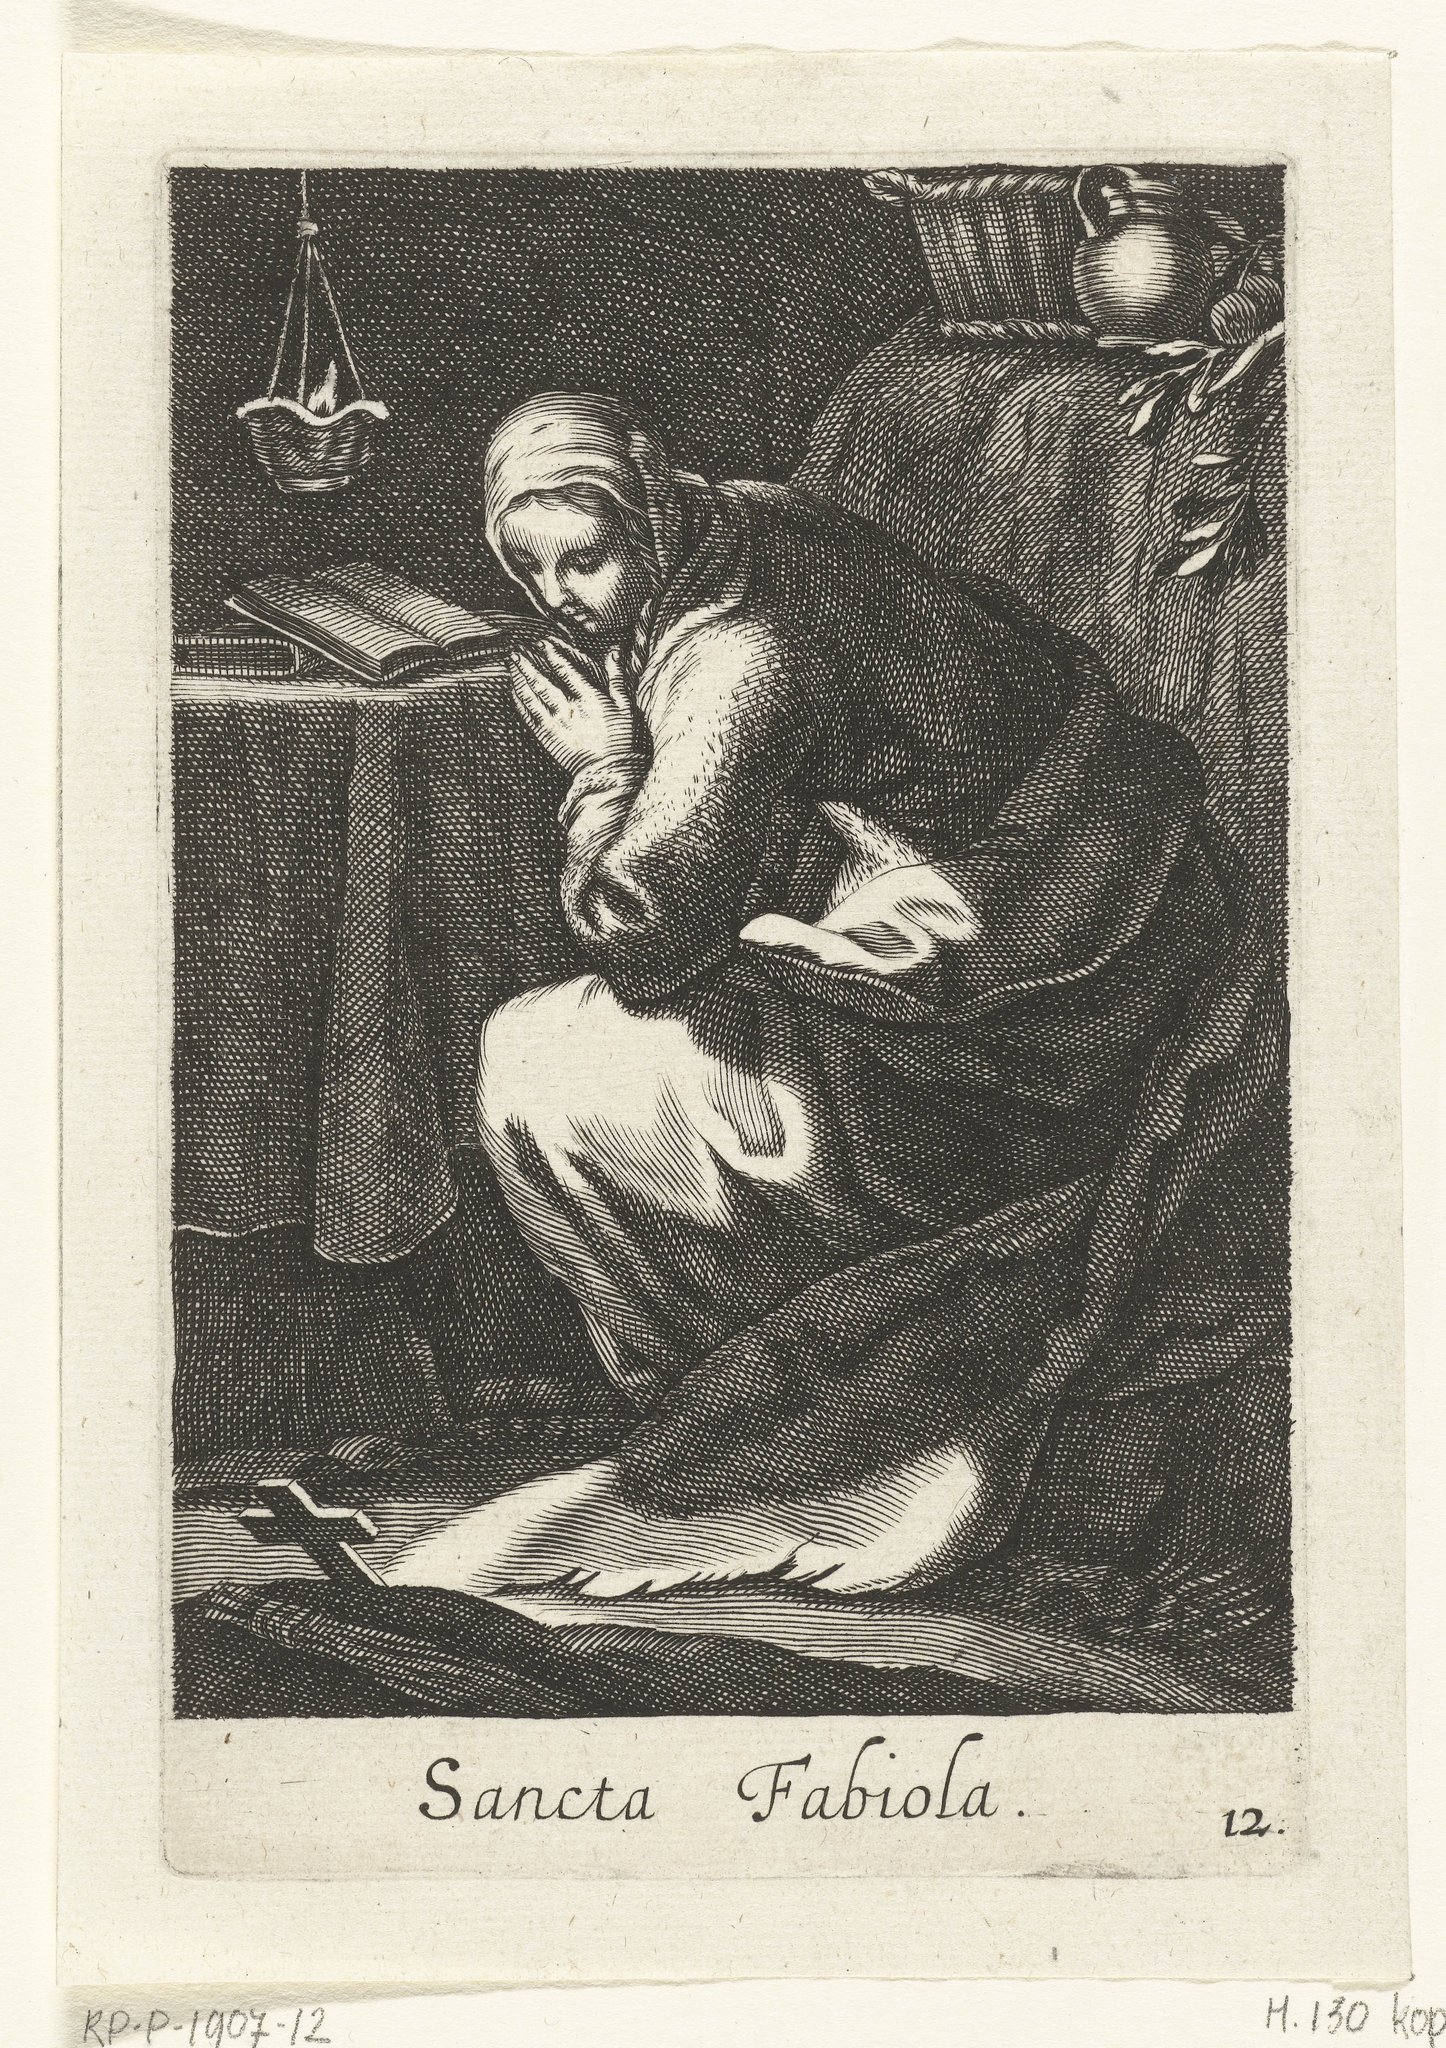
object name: print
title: Sancta Fabiola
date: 1590-1662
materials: paper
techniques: engraving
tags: anchorite, hermit, female saints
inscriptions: collector's mark: Lugt 2228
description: Kopie in spiegelbeeld naar prent van Boëtius Adamsz. Bolswert uit serie Kluizenaressen.